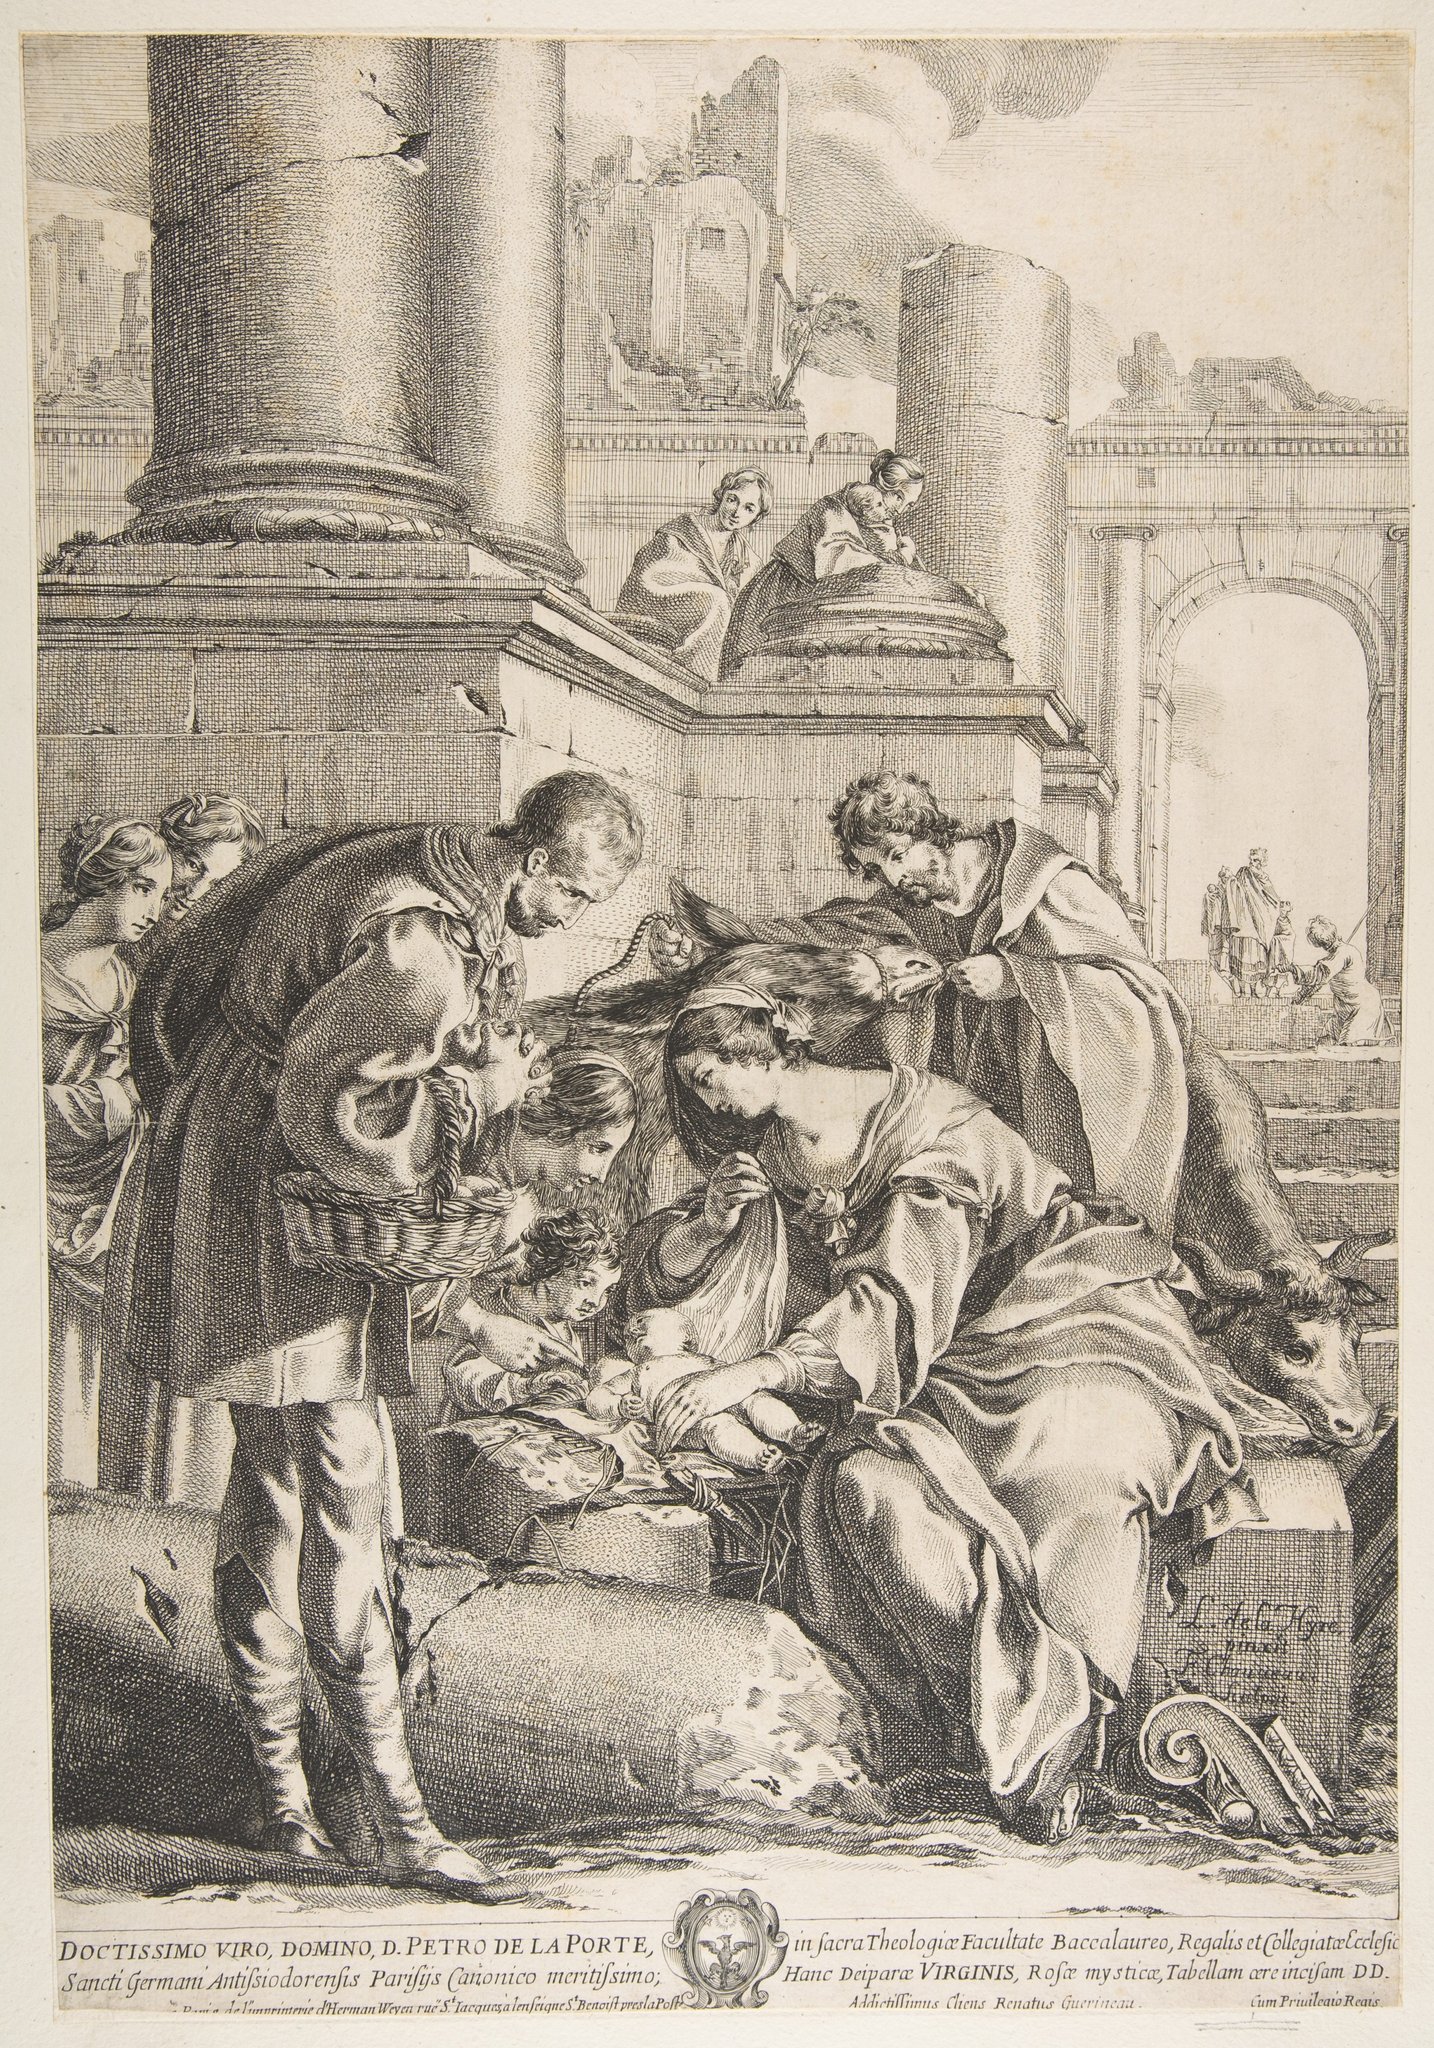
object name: print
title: Adoration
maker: françois chauveau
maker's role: artist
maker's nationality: french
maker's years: 1613-1676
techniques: etching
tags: human figures,madonna and child,adoration of the magi